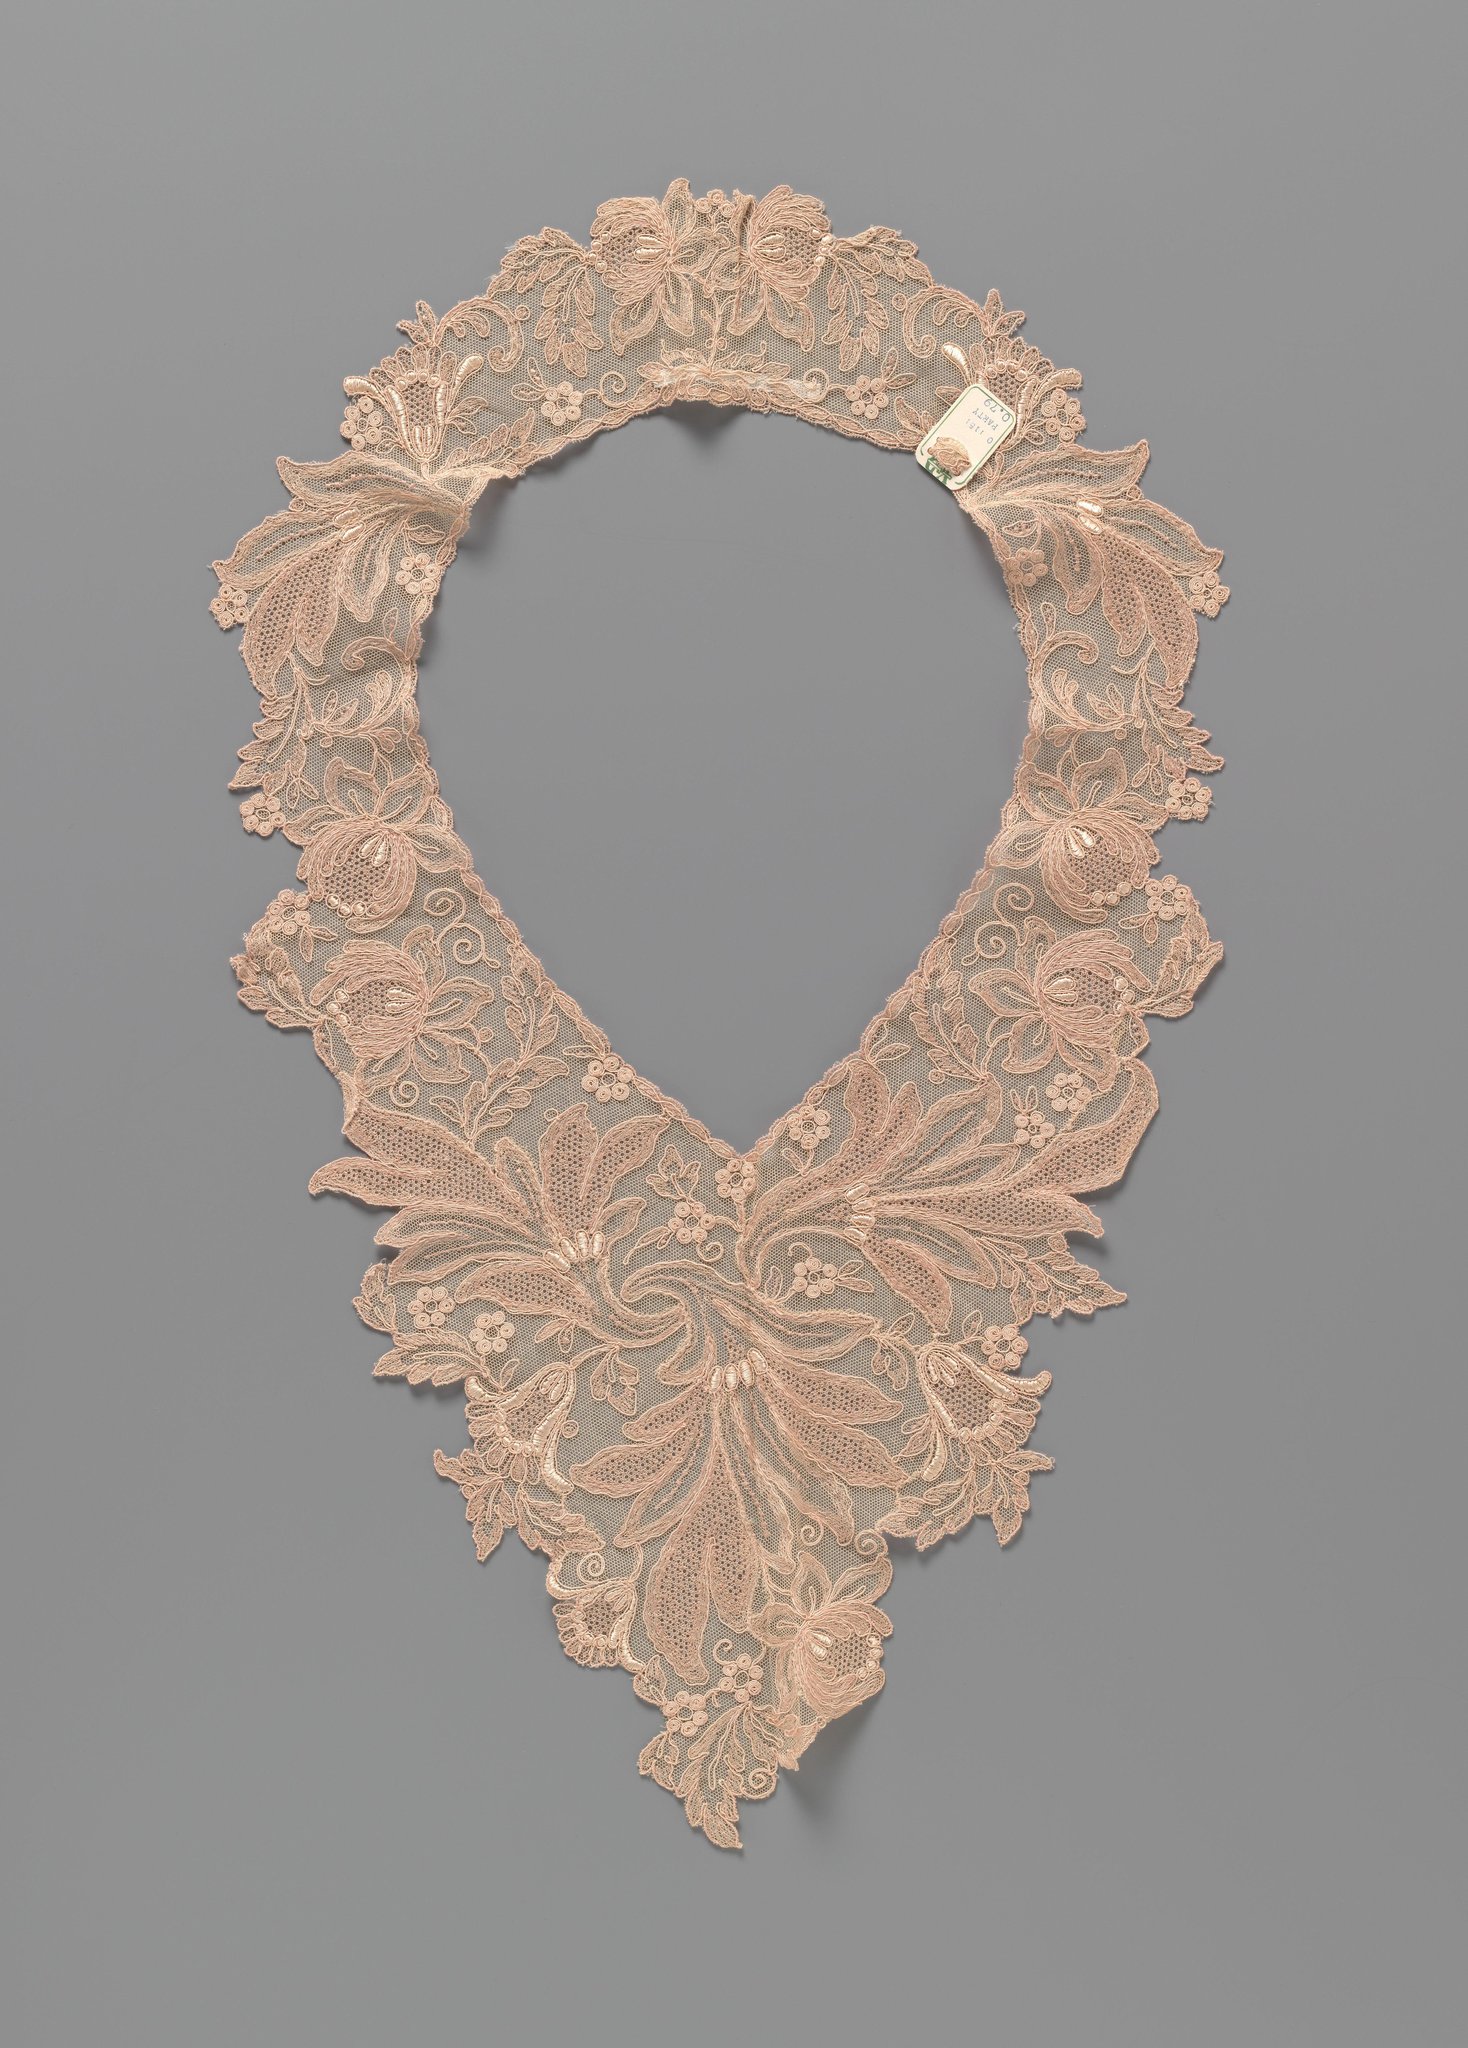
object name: belegstuk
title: Applicatie van machinale kant voor een ronde halslijn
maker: Anonymous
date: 1920-1930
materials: cotton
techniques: lace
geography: england